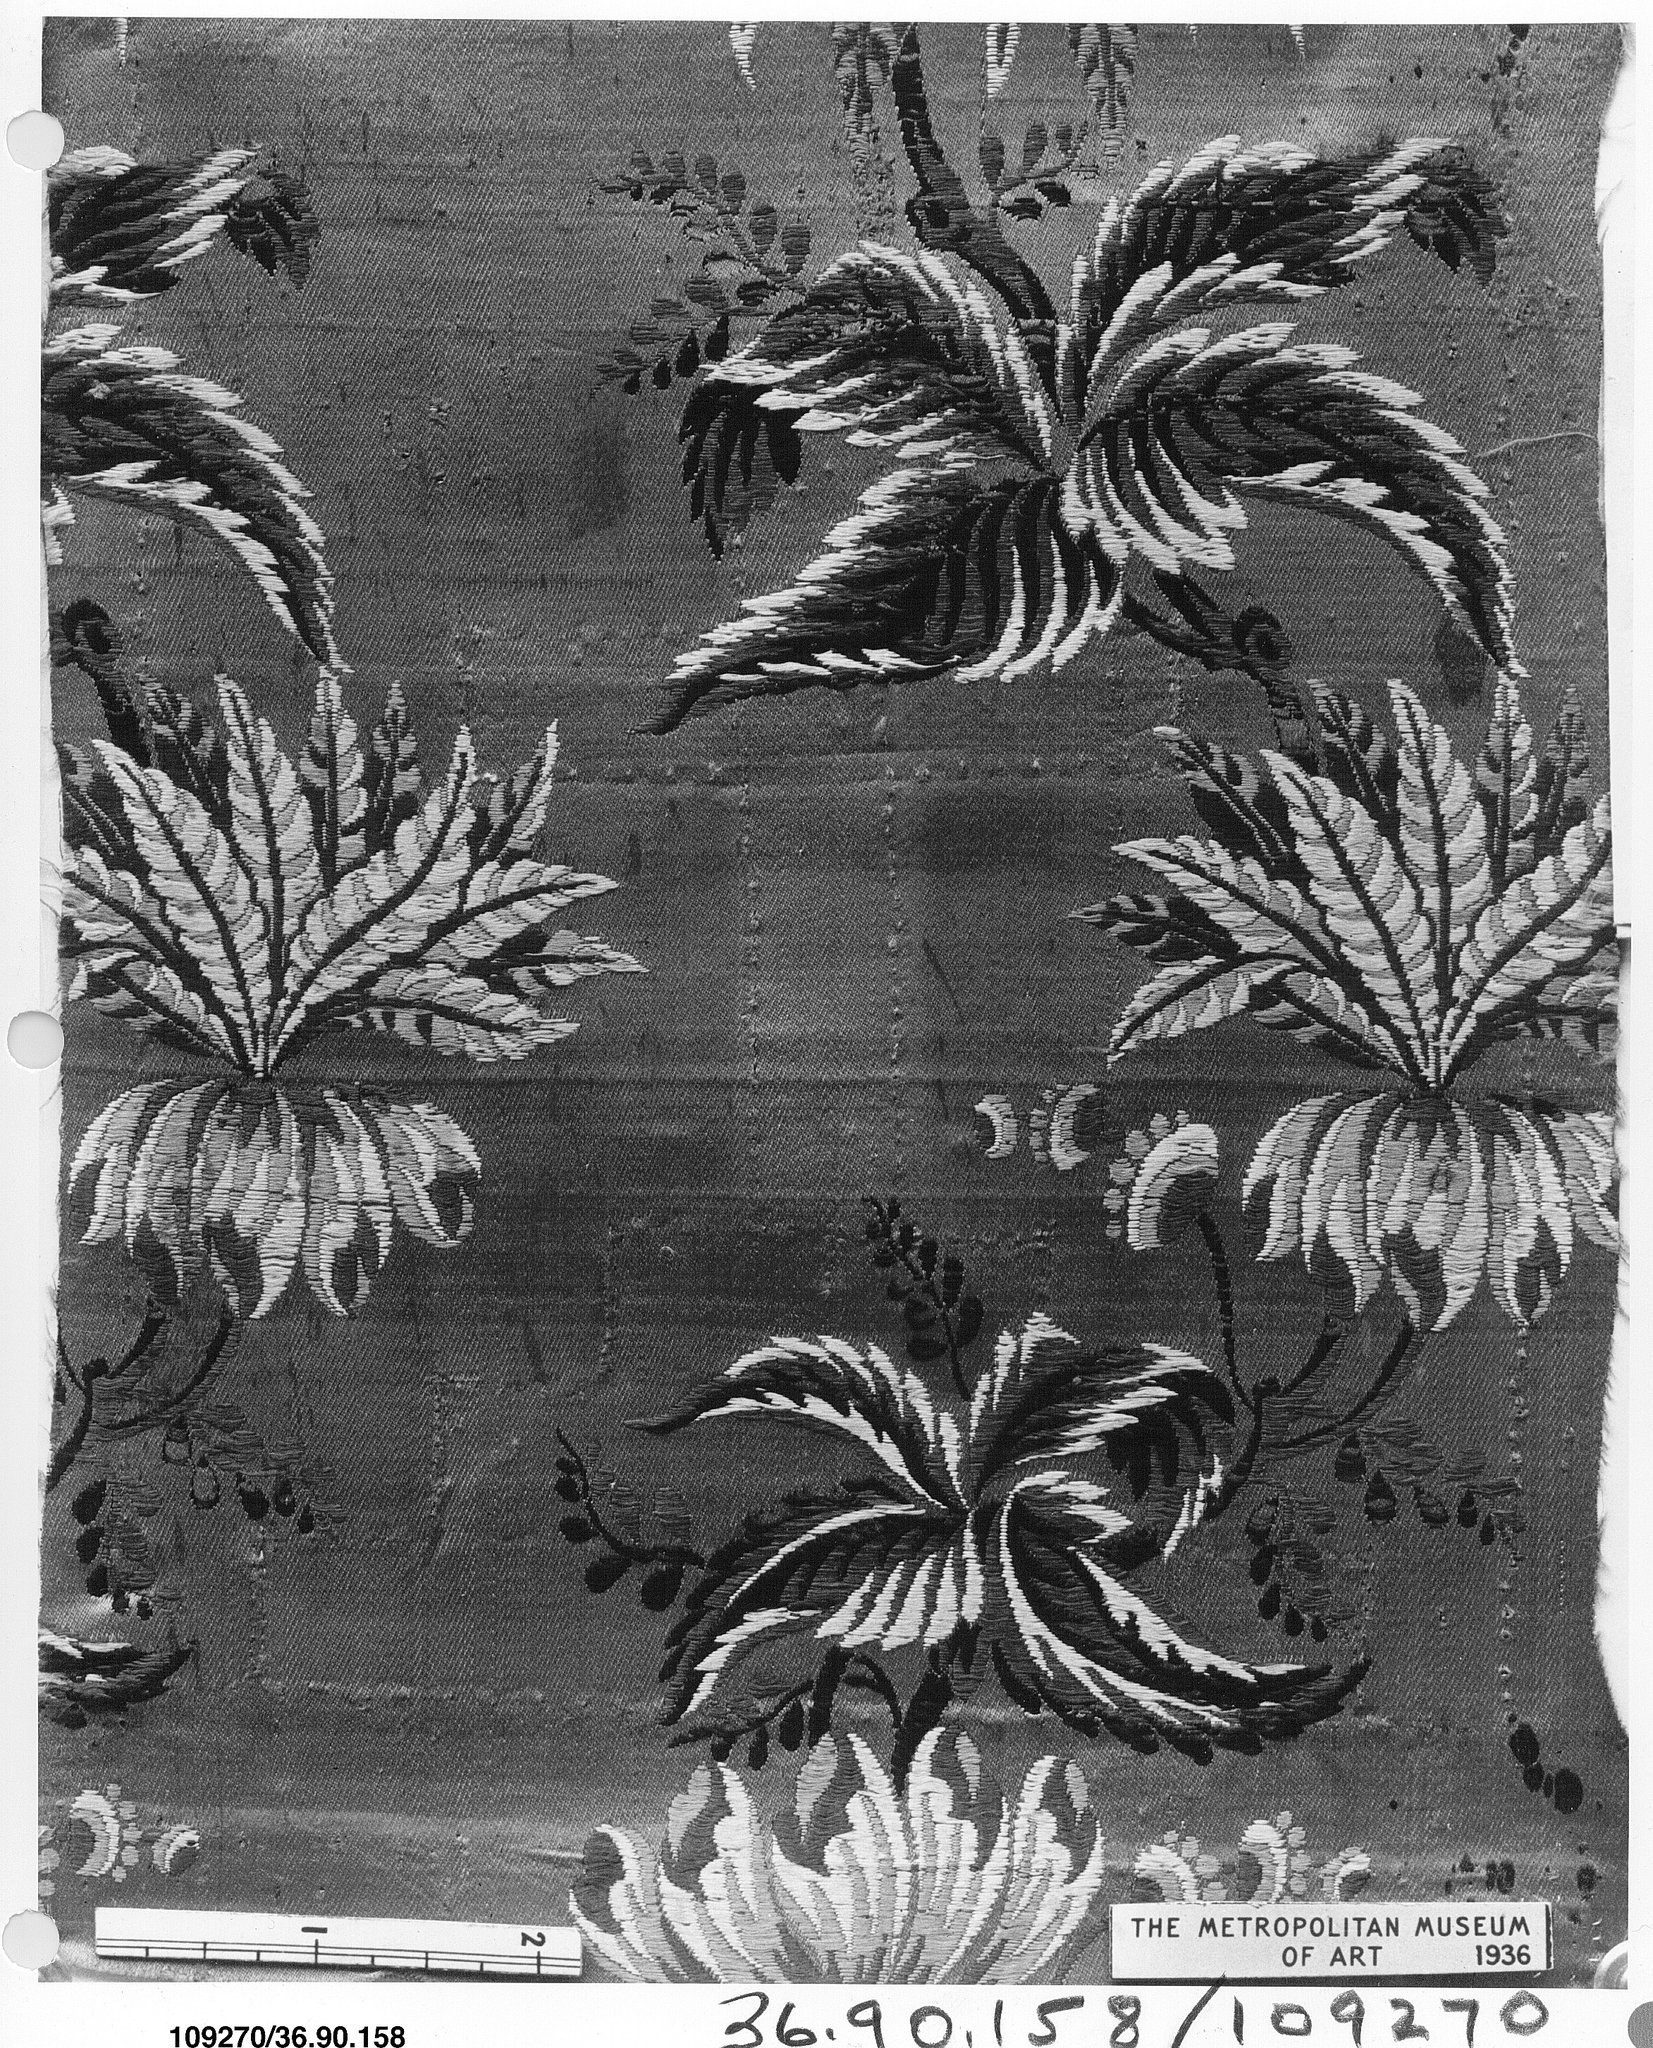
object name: piece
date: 1740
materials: silk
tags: leaves